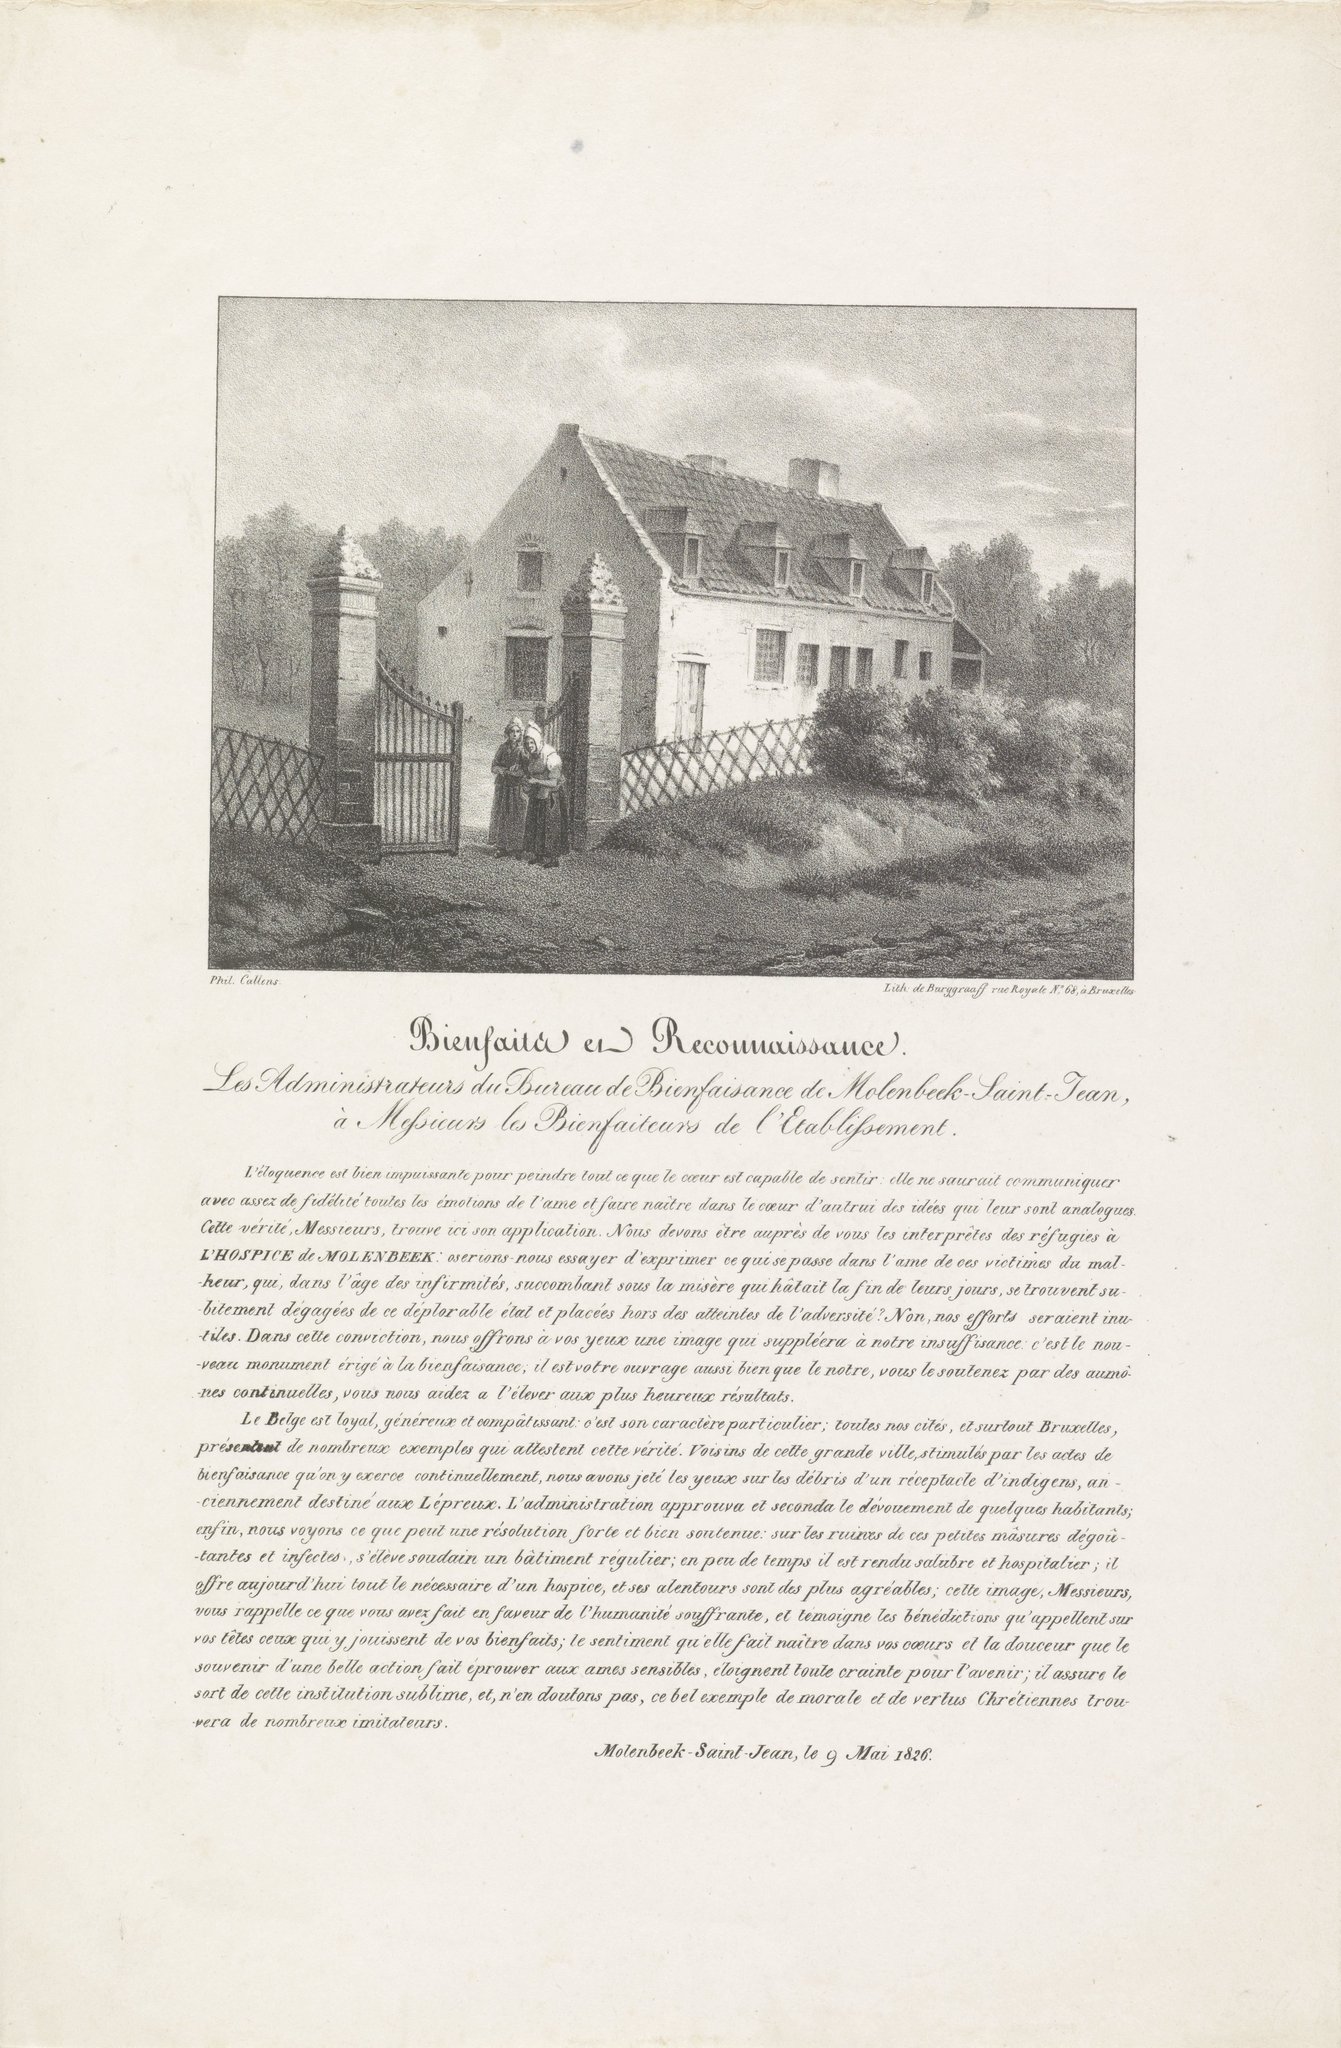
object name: print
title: Bienfaits et Reconnaissance. Les Administrateurs du Bureau de Bienfaisance de Molenbeek-Saint-Jean, à Messieurs les Bienfaiteurs de l'Etablissement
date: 1826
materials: paper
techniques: lithograph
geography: brussels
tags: public welfare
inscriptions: collector's mark: Lugt 2228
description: Opening van een liefdadigheidsgeschicht in Sint-Jans-Molenbeek bij Brussel voor de opvang van zieke armen, 9 mei 1826. Twee vrouwen staande voor de poort naar de inrichting. Onder de plaat een Frans onderschrift naar aanleiding van de opening.